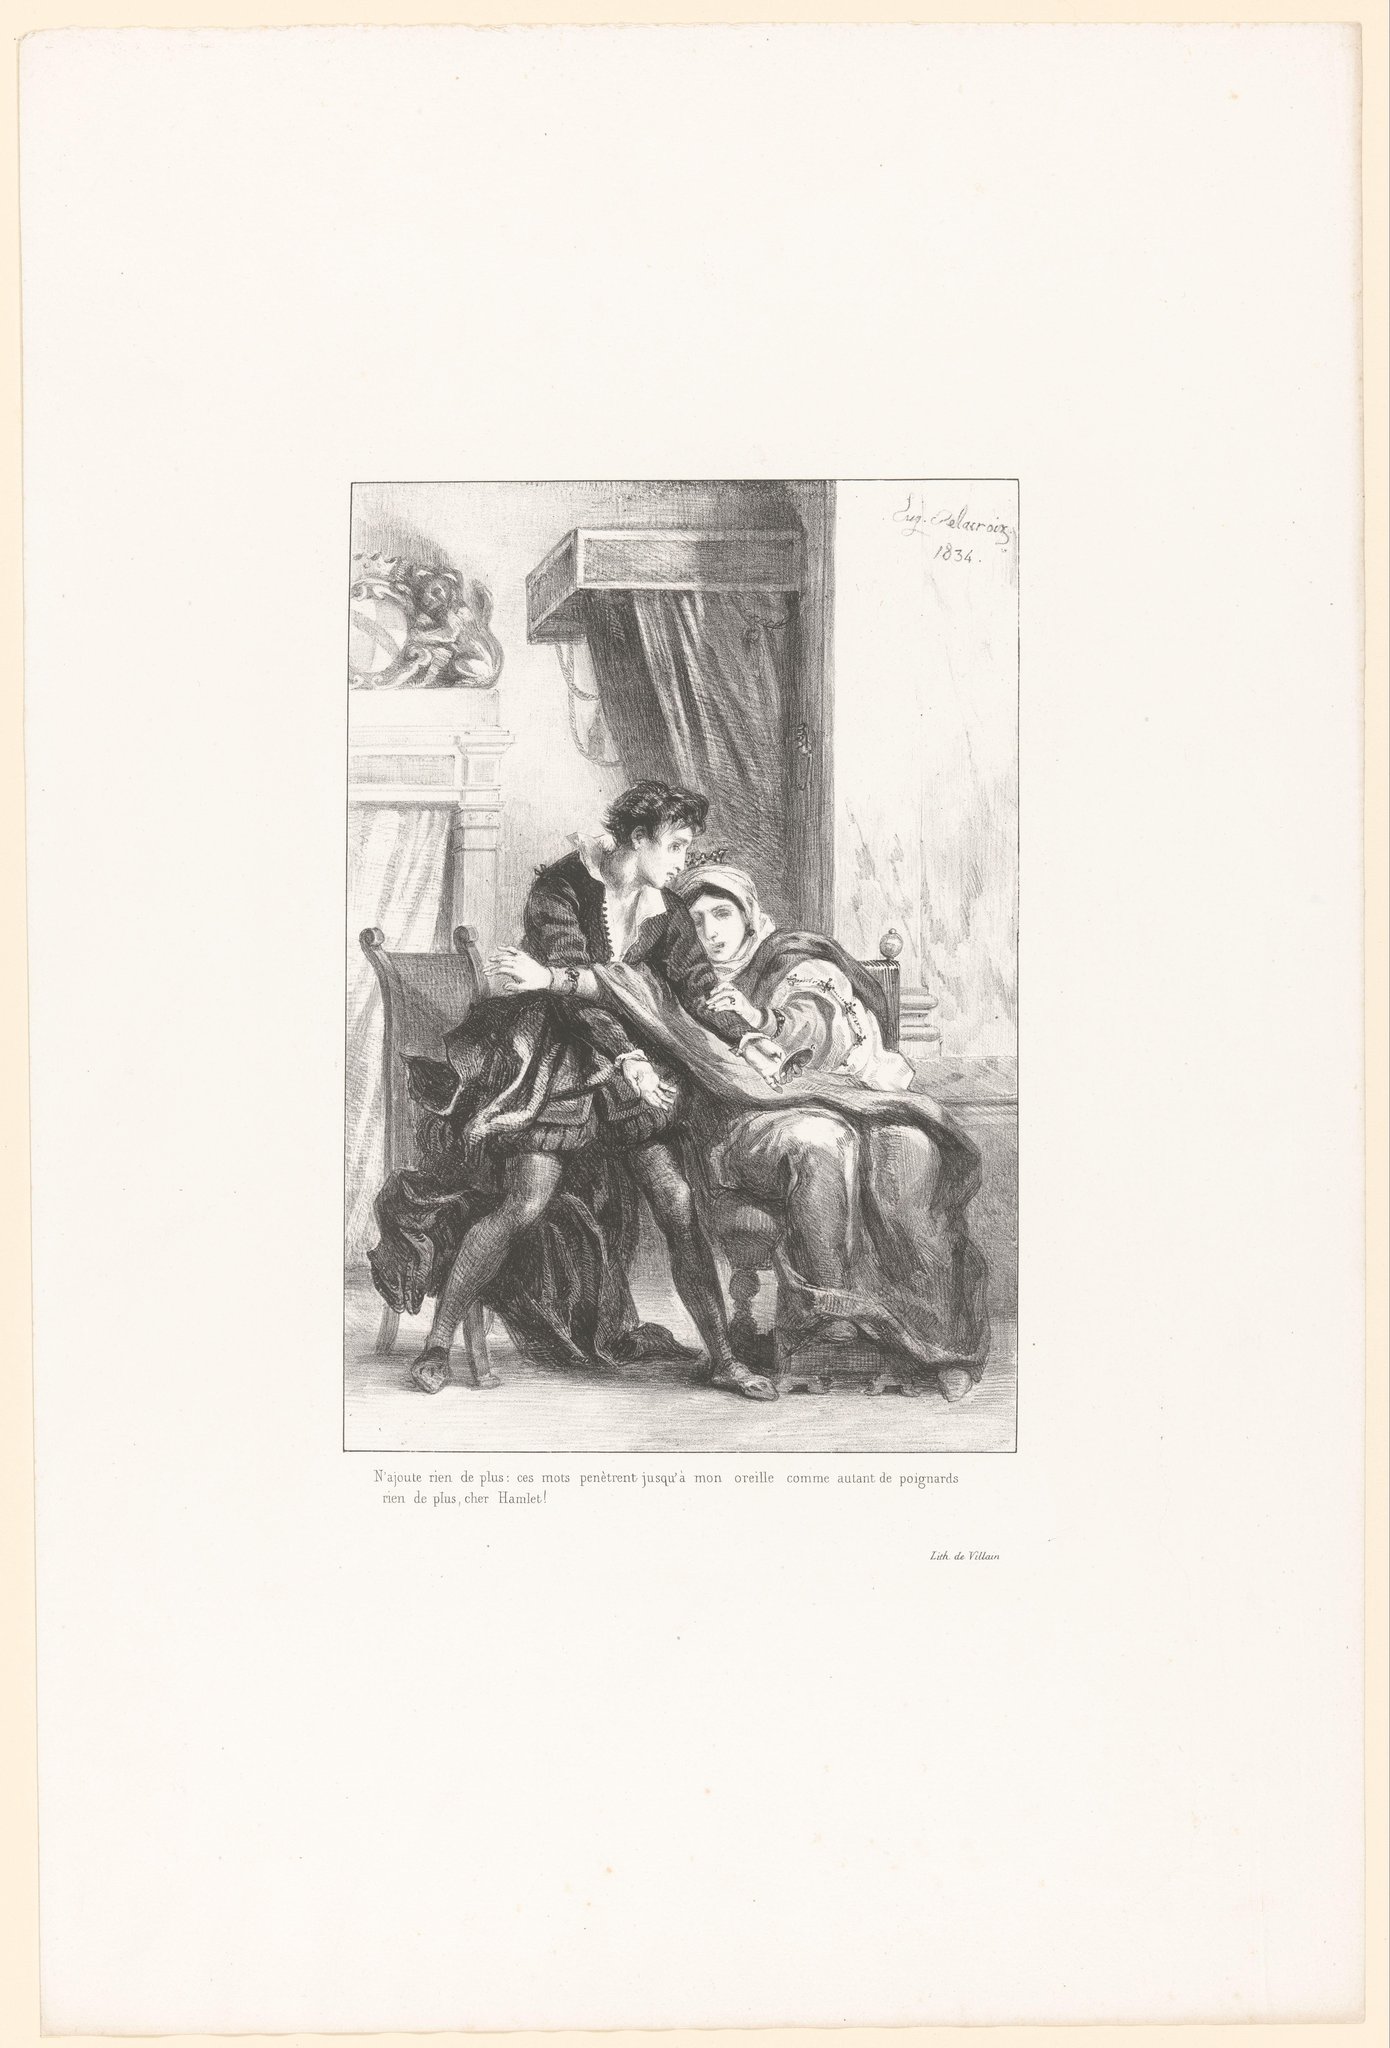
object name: print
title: Hamlet en koningin Gertrude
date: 1834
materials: paper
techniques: lithograph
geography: paris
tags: hamlet, prince of denmark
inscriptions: collector's mark: Lugt 2760, collector's mark: Lugt 2228a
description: Prent maakt deel uit van een omslag met veertien prenten.